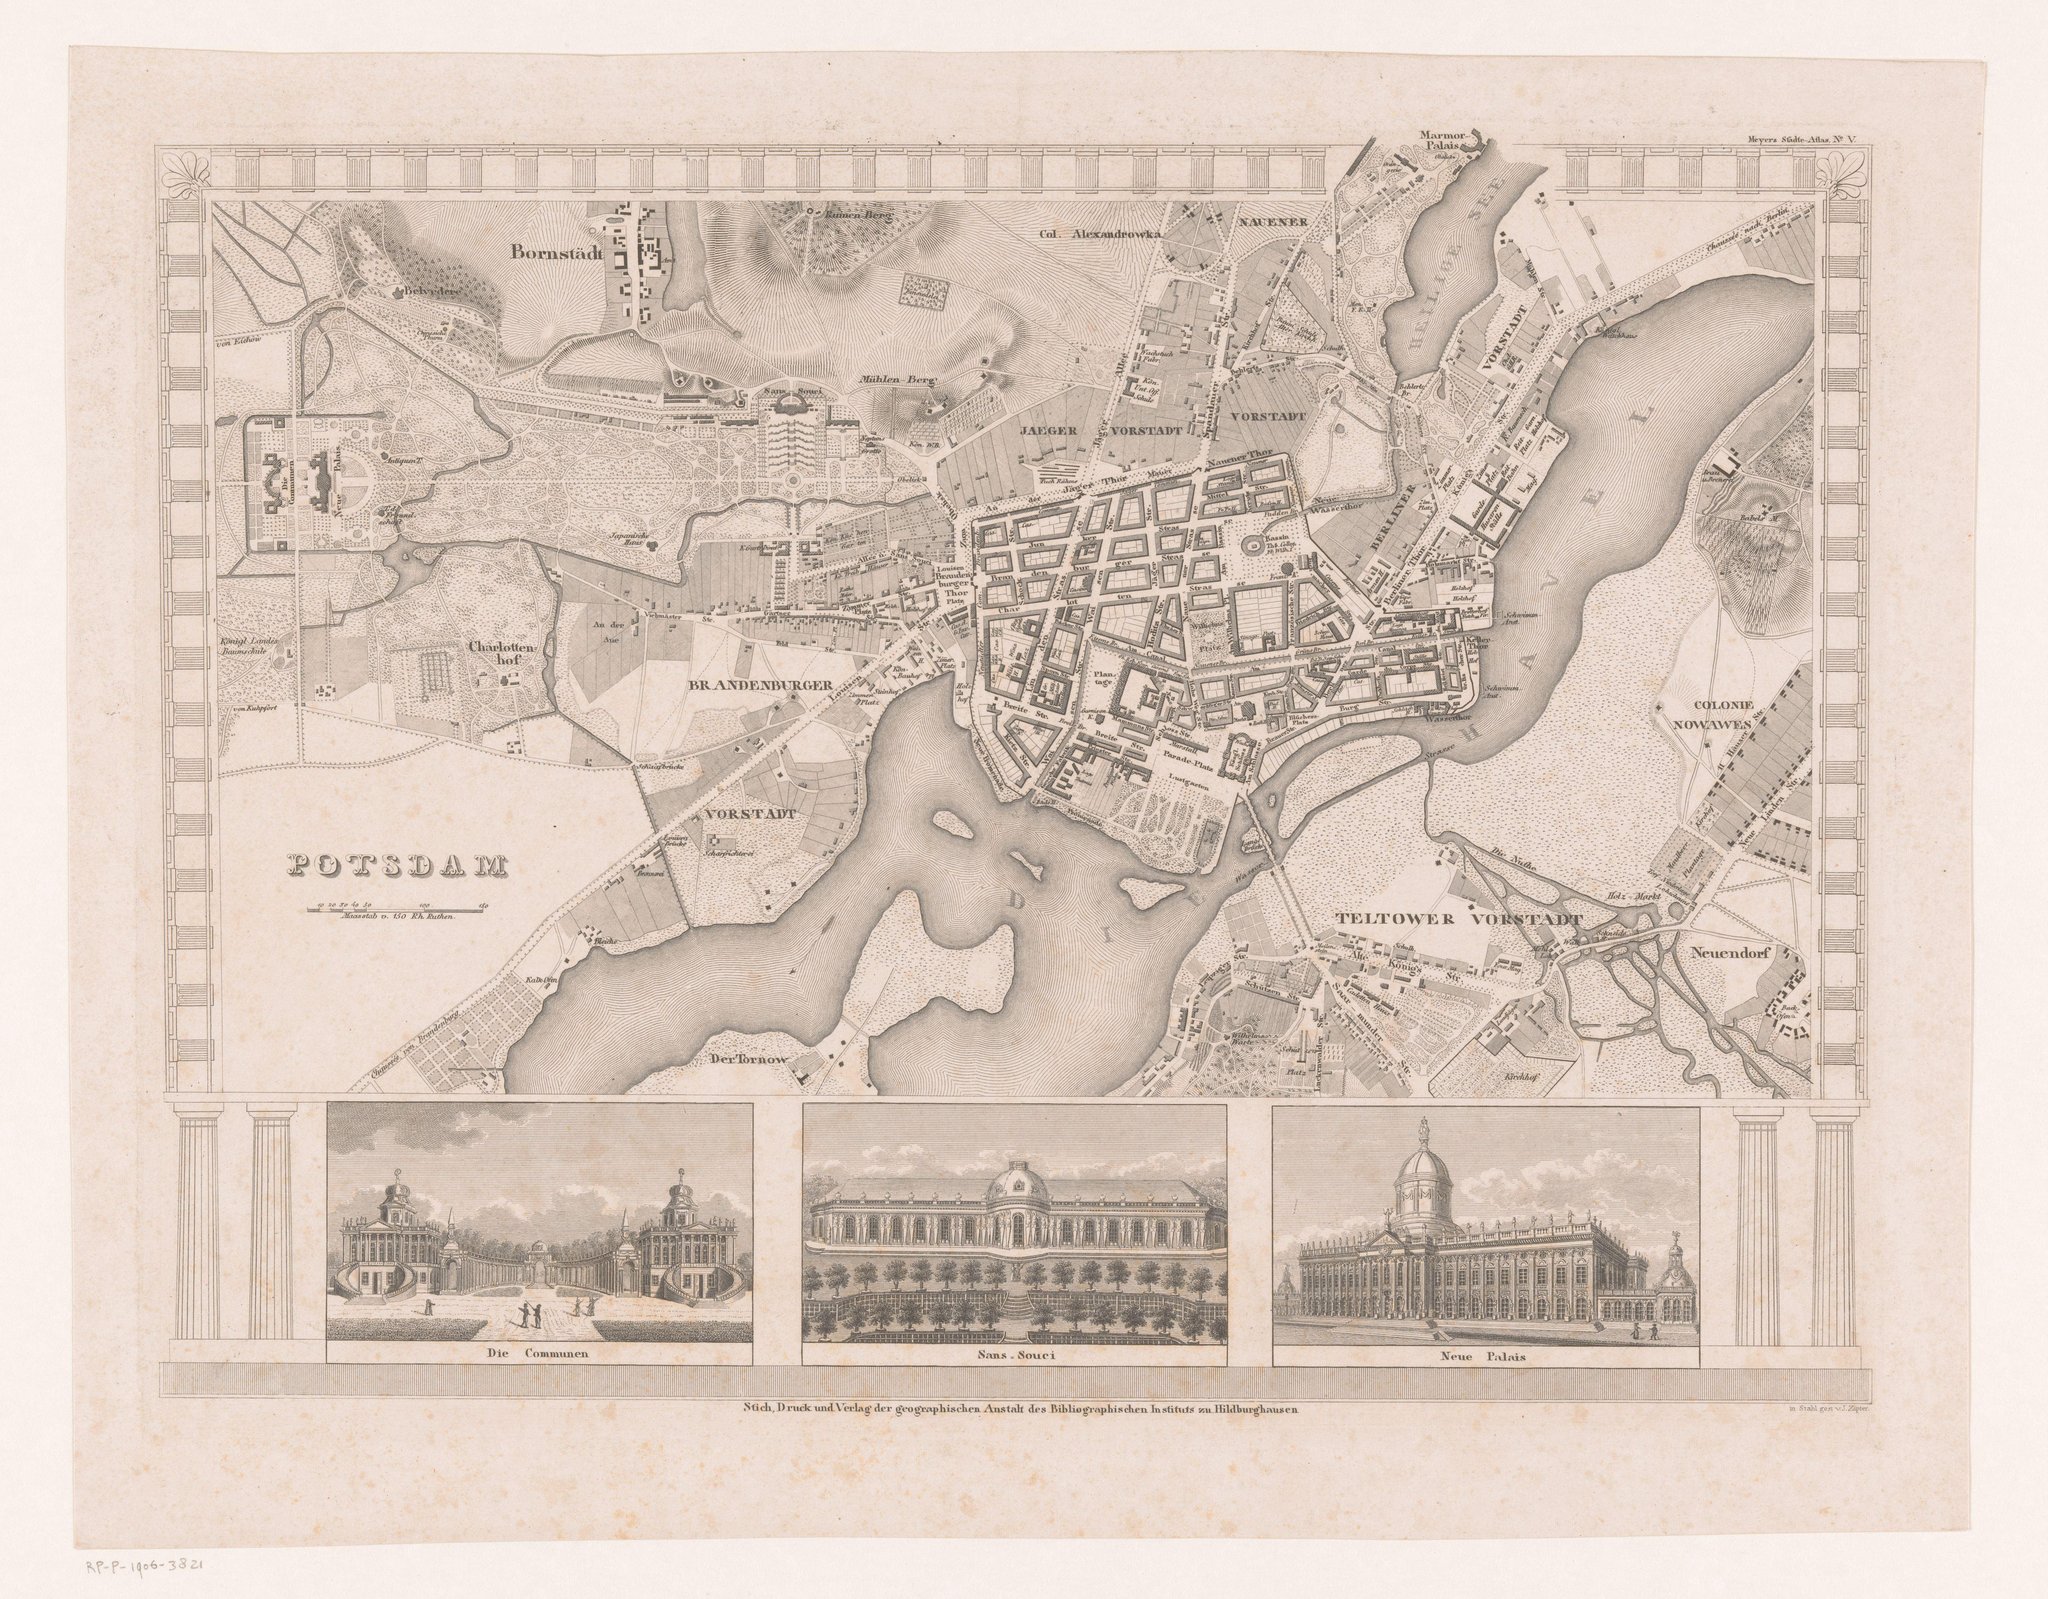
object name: print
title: Plattegrond van Potsdam met drie details van gebouwen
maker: j. zipter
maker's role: print maker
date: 1828-1874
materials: paper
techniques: engraving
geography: hildburghausen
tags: maps of cities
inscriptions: collector's mark: Lugt 2228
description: Prent gebruikt voor Joseph Meyers 'Stadte Atlas'.